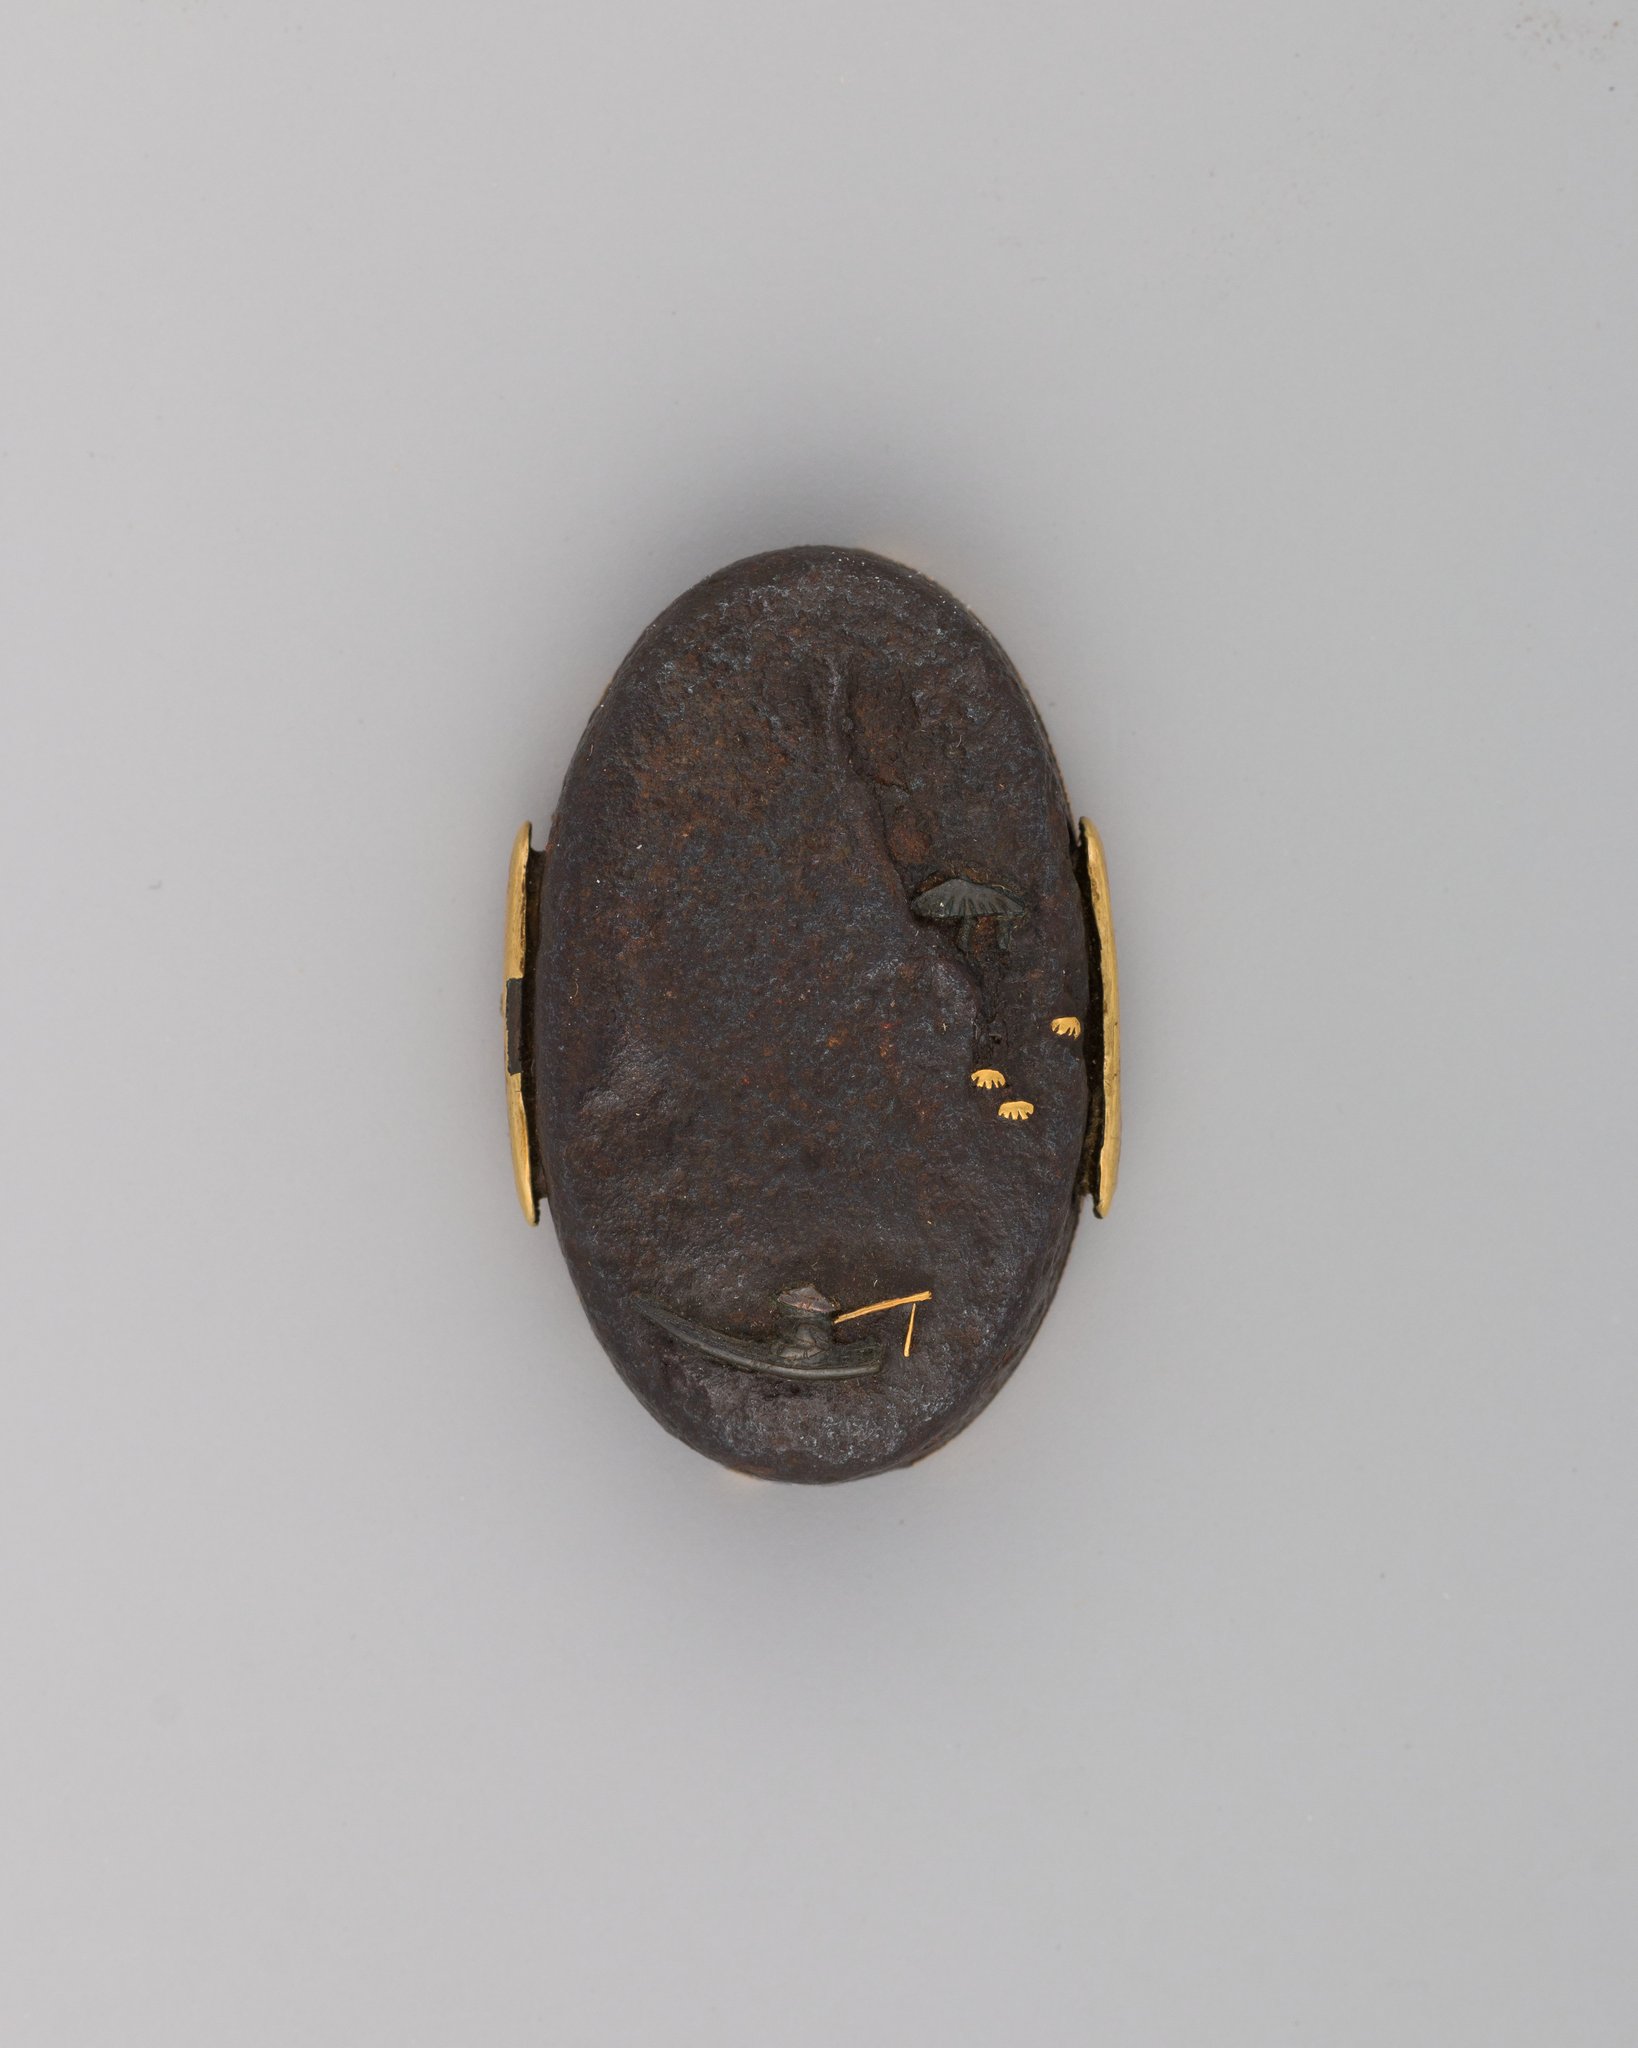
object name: sword pommel kashira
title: Sword Pommel (Kashira)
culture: japanese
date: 1601-1700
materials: gold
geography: japan